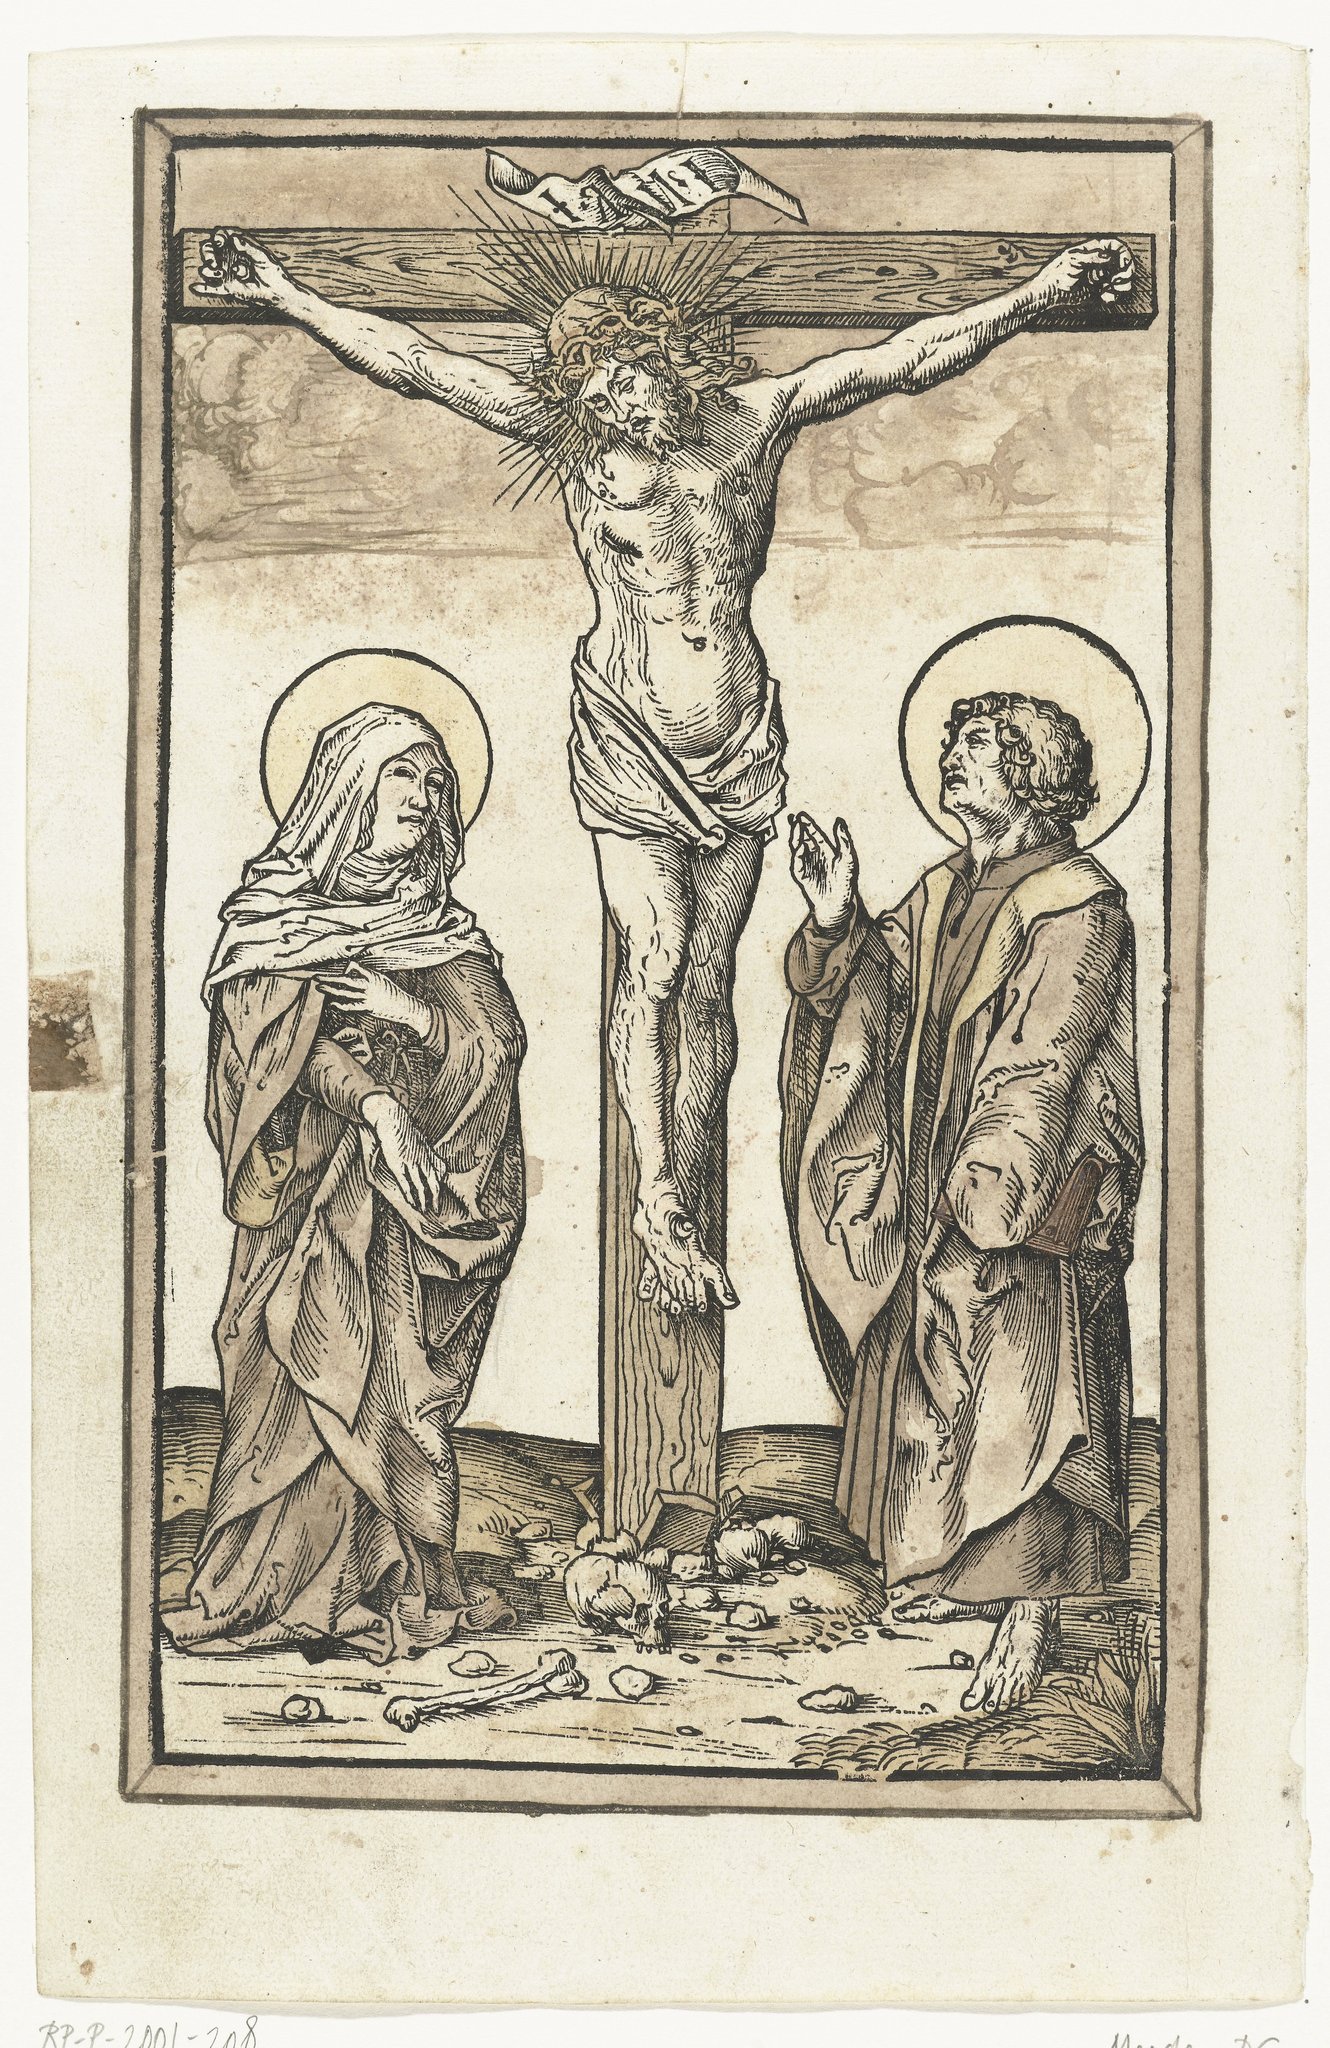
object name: print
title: Christus aan het kruis, met Maria en Johannes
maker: monogrammist ds (graveur)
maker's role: print maker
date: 1500-1520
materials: paper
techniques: hand coloring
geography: germany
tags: crucified christ with mary and john on either side of the cross; holy rood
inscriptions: collector's mark: Lugt 2228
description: Christus aan het kruis, aan zijn rechterhand Maria, aan zijn linker Johannes. Met penseel zijn wolken en een omlijsting getekend.